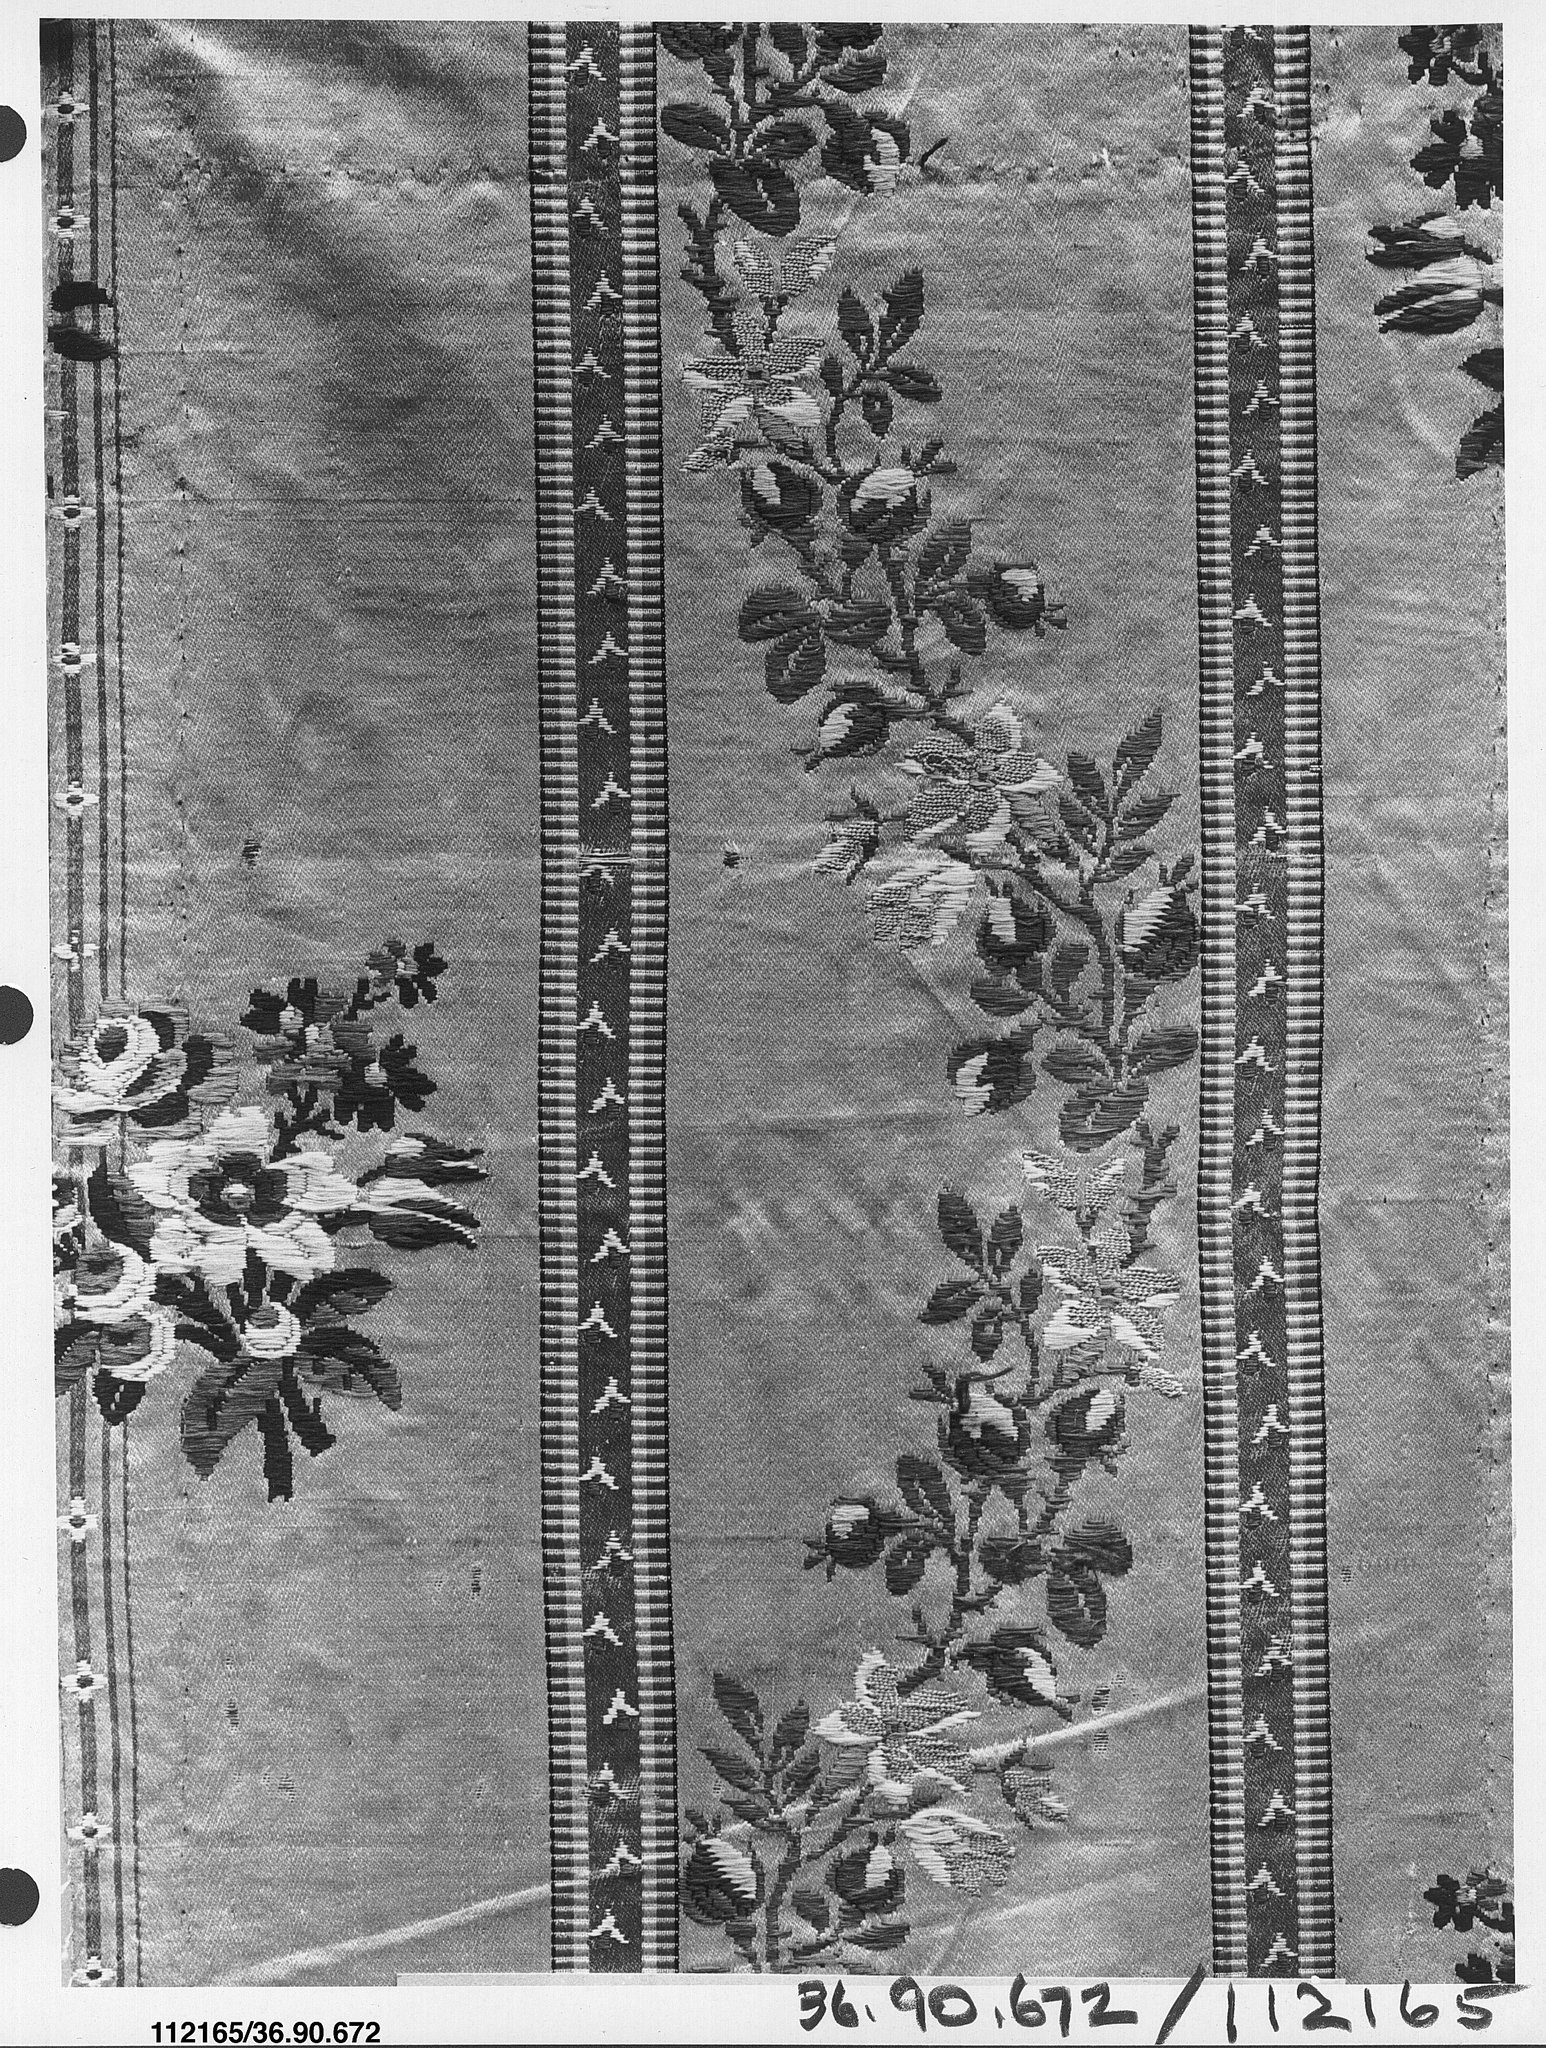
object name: piece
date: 1701-1800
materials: silk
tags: flowers,leaves